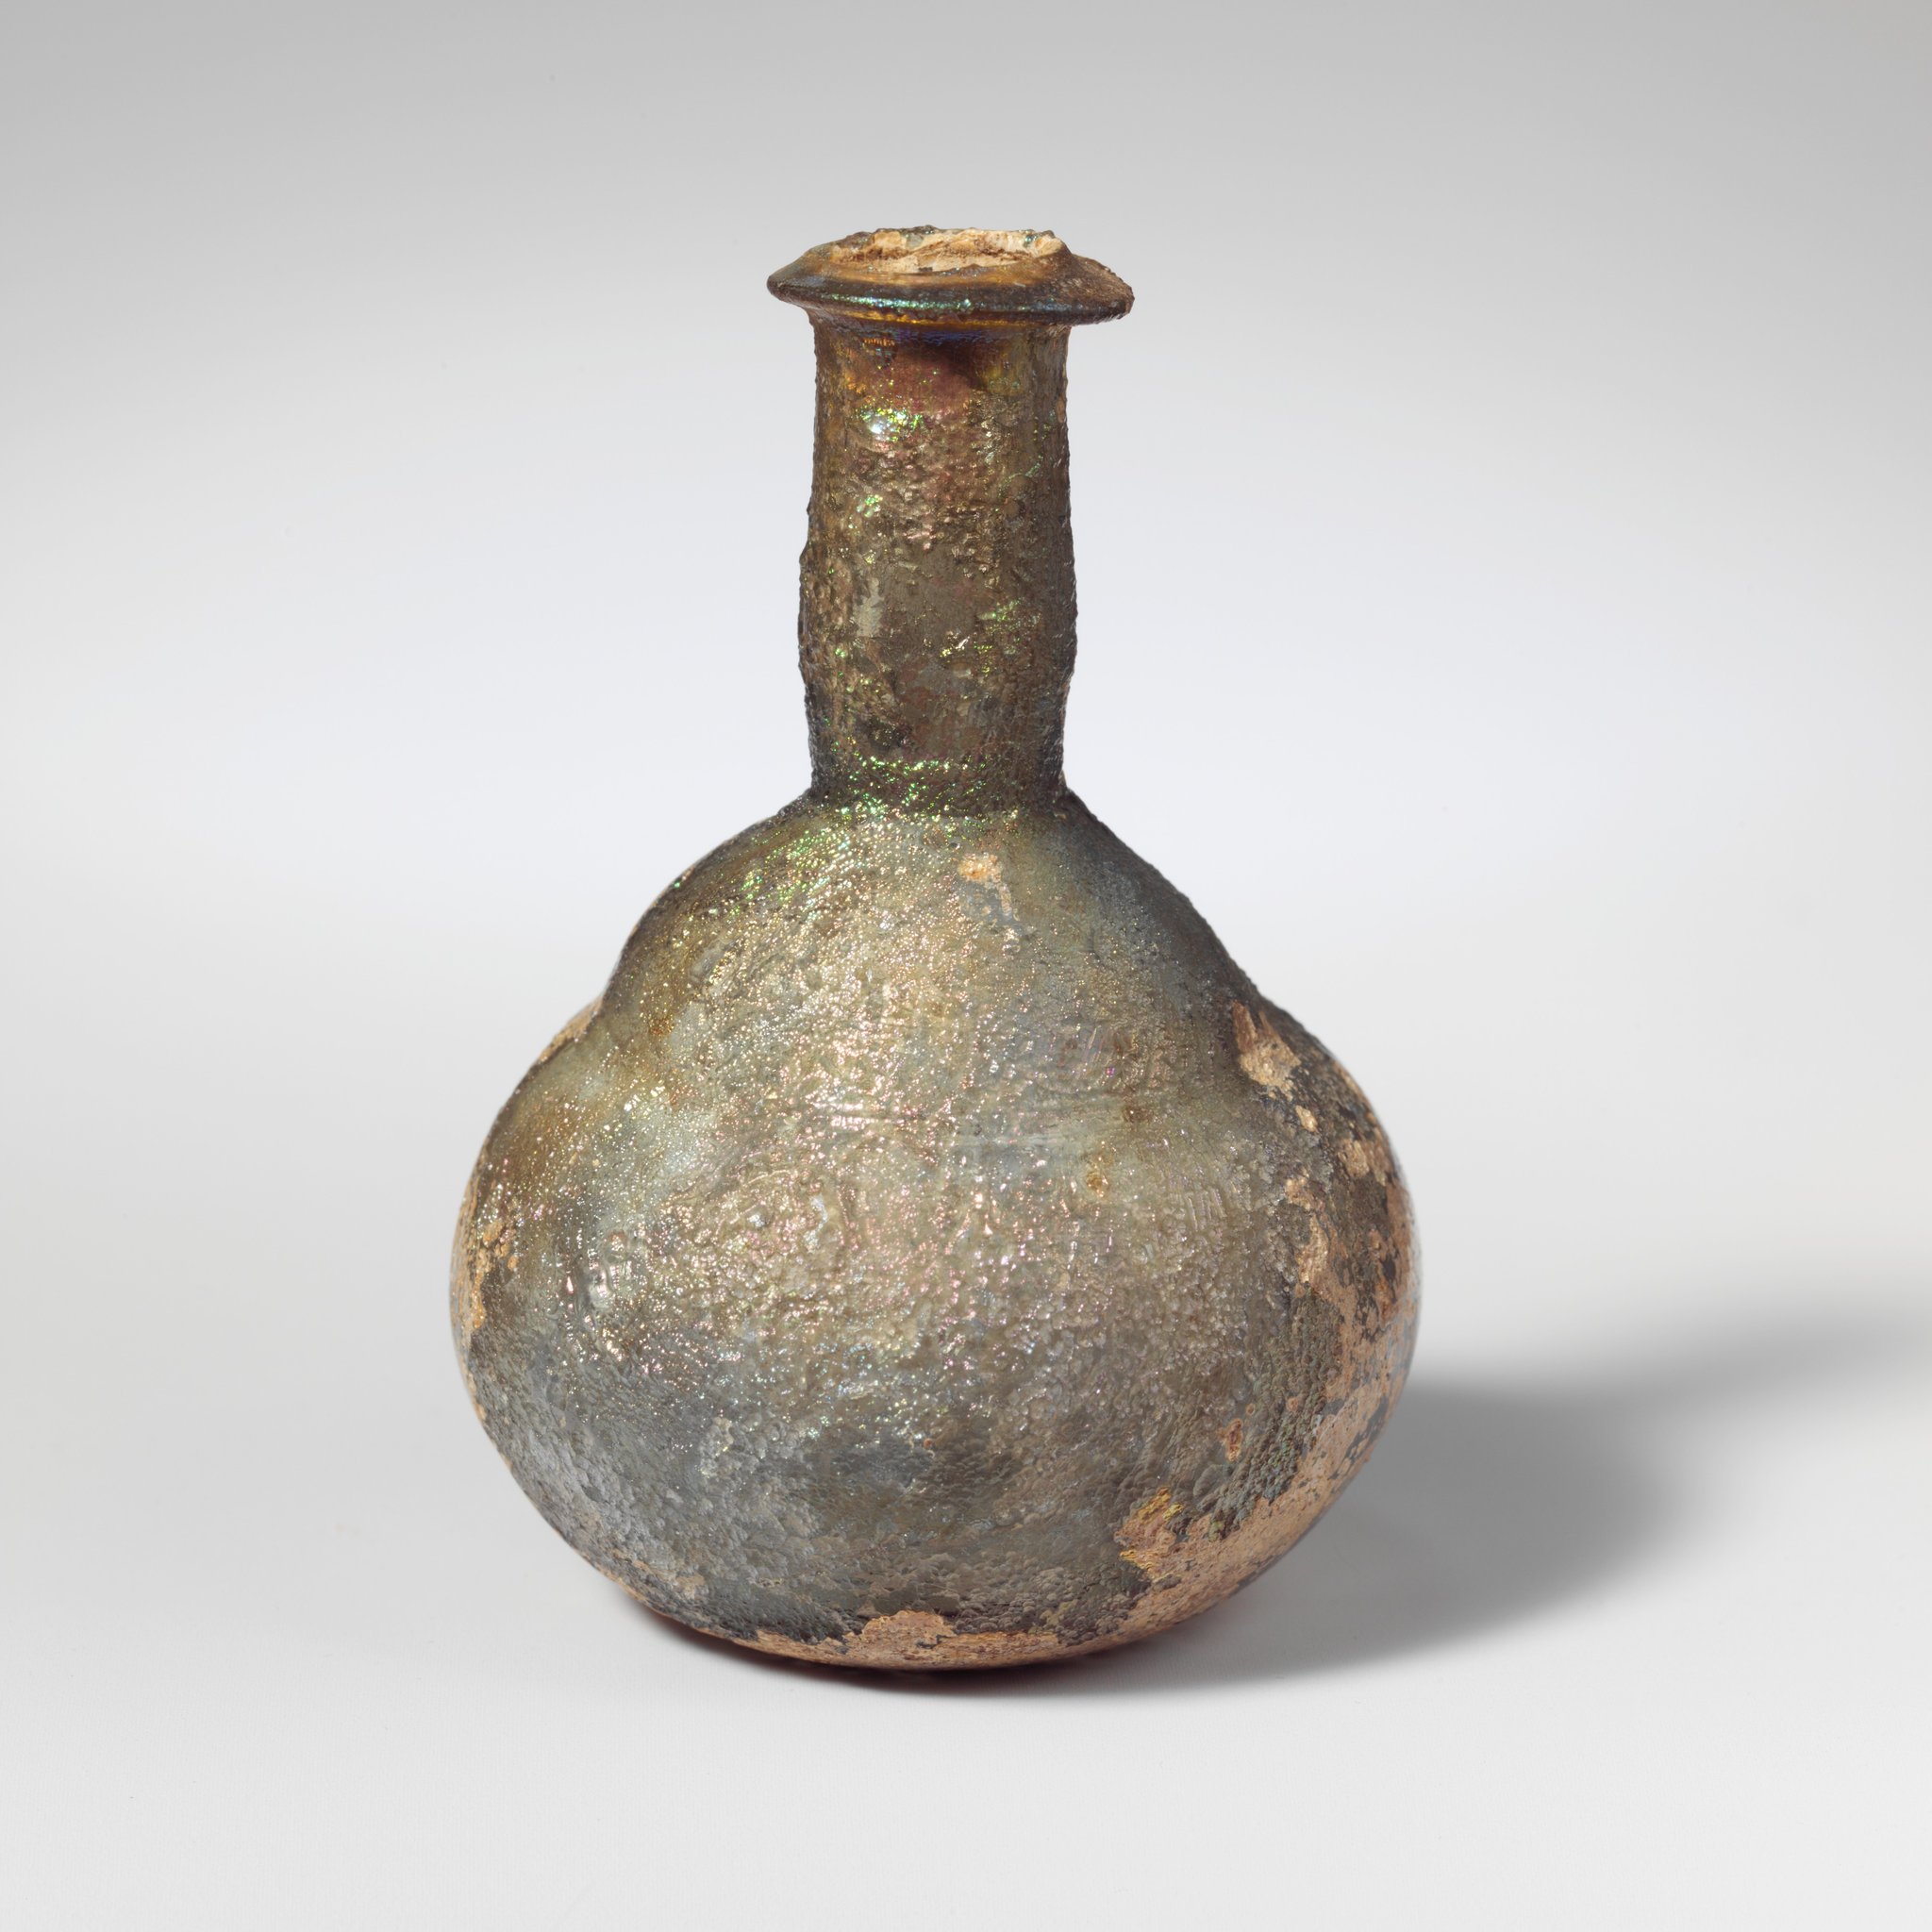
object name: perfume bottle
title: Glass perfume bottle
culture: roman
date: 1-100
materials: glass